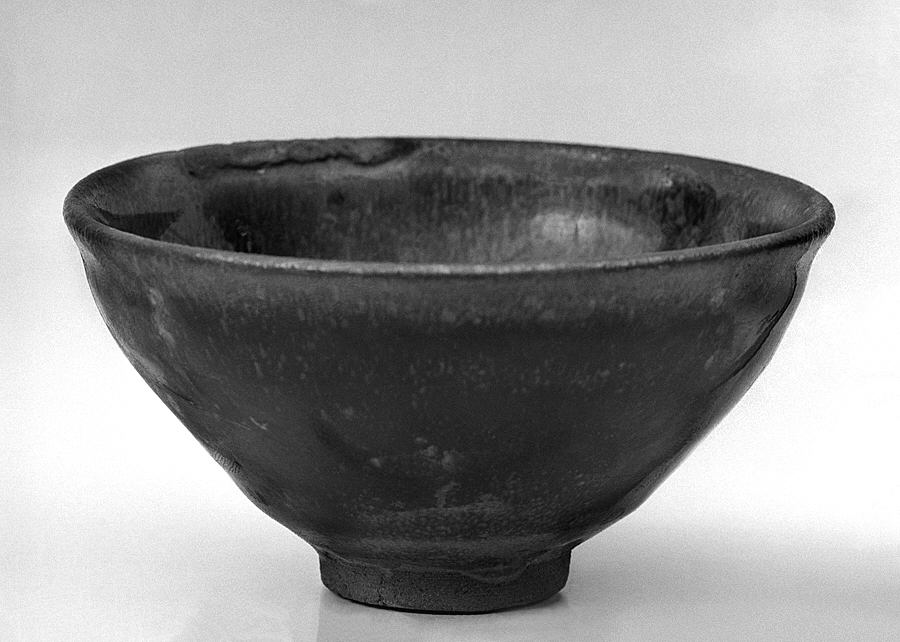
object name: bowl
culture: chinese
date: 960-1279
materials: glaze